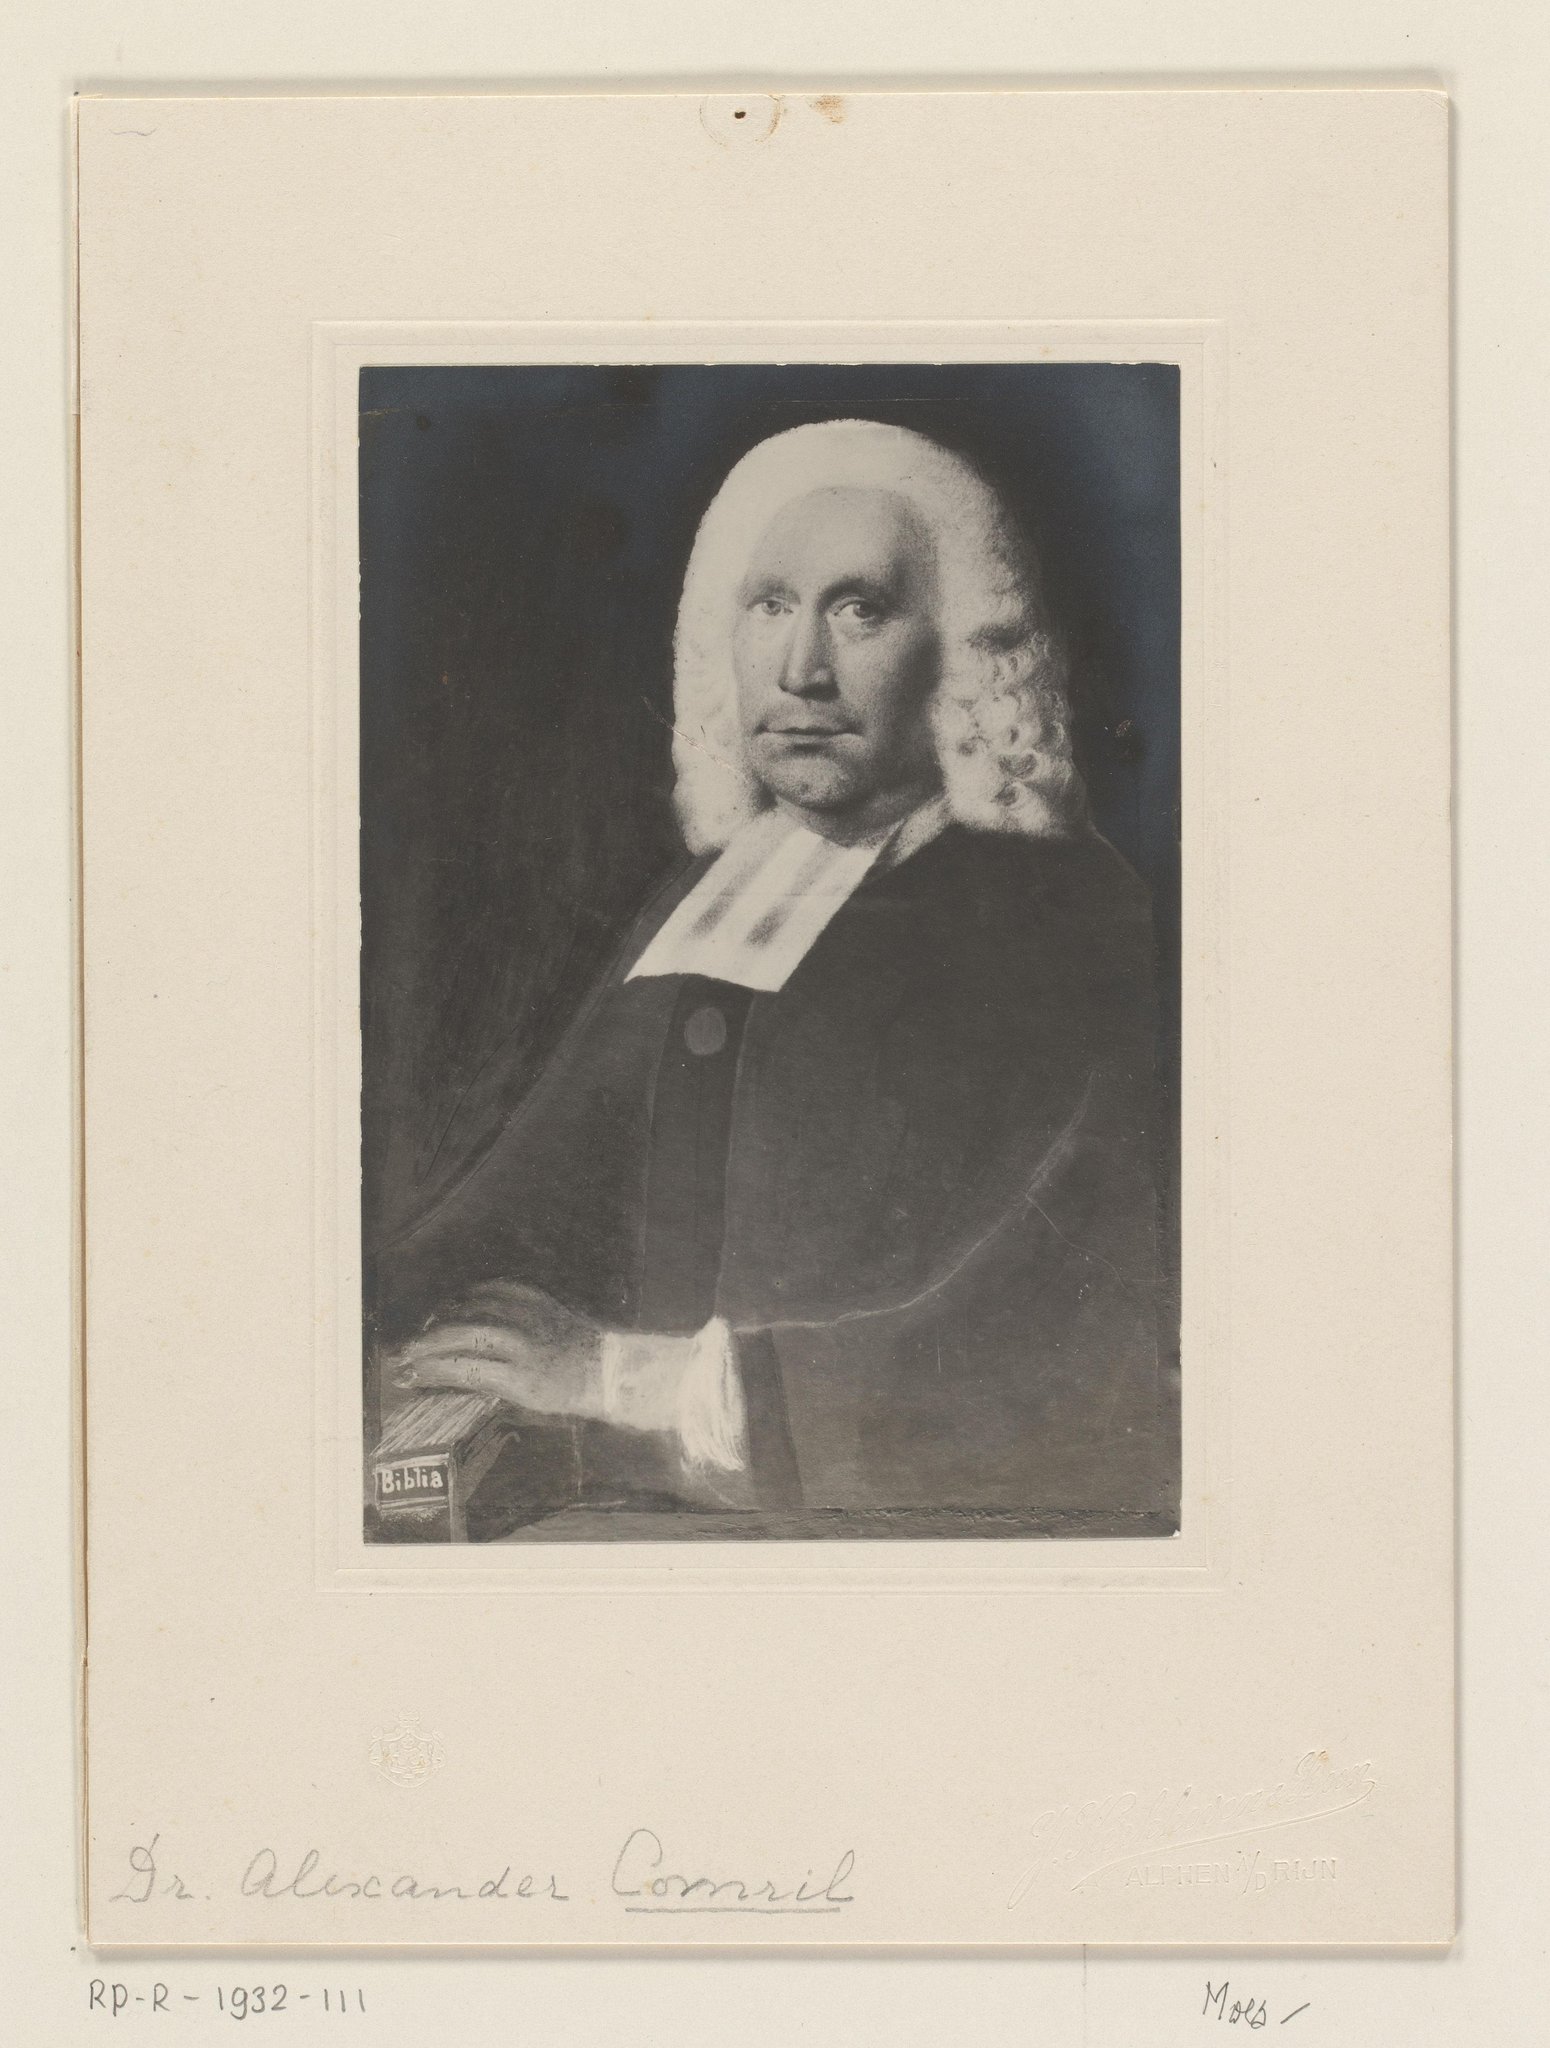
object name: photograph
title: Fotoreproductie van een geschilderd portret van Alexander Comrie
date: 1900-1932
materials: paper, cardboard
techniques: gelatin silver print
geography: alphen aan den rijn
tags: gouda, historical persons, picture, painting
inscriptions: inscription: ‘Dr. Alexander Comrie’, inscription: ‘Dr. Alexander Comrie/ predikant te Woubrugge 1735-73/ voor ??/ oudheidverzameling Woubrugge./ Zie ingekomen stukken 21/11 1932.’